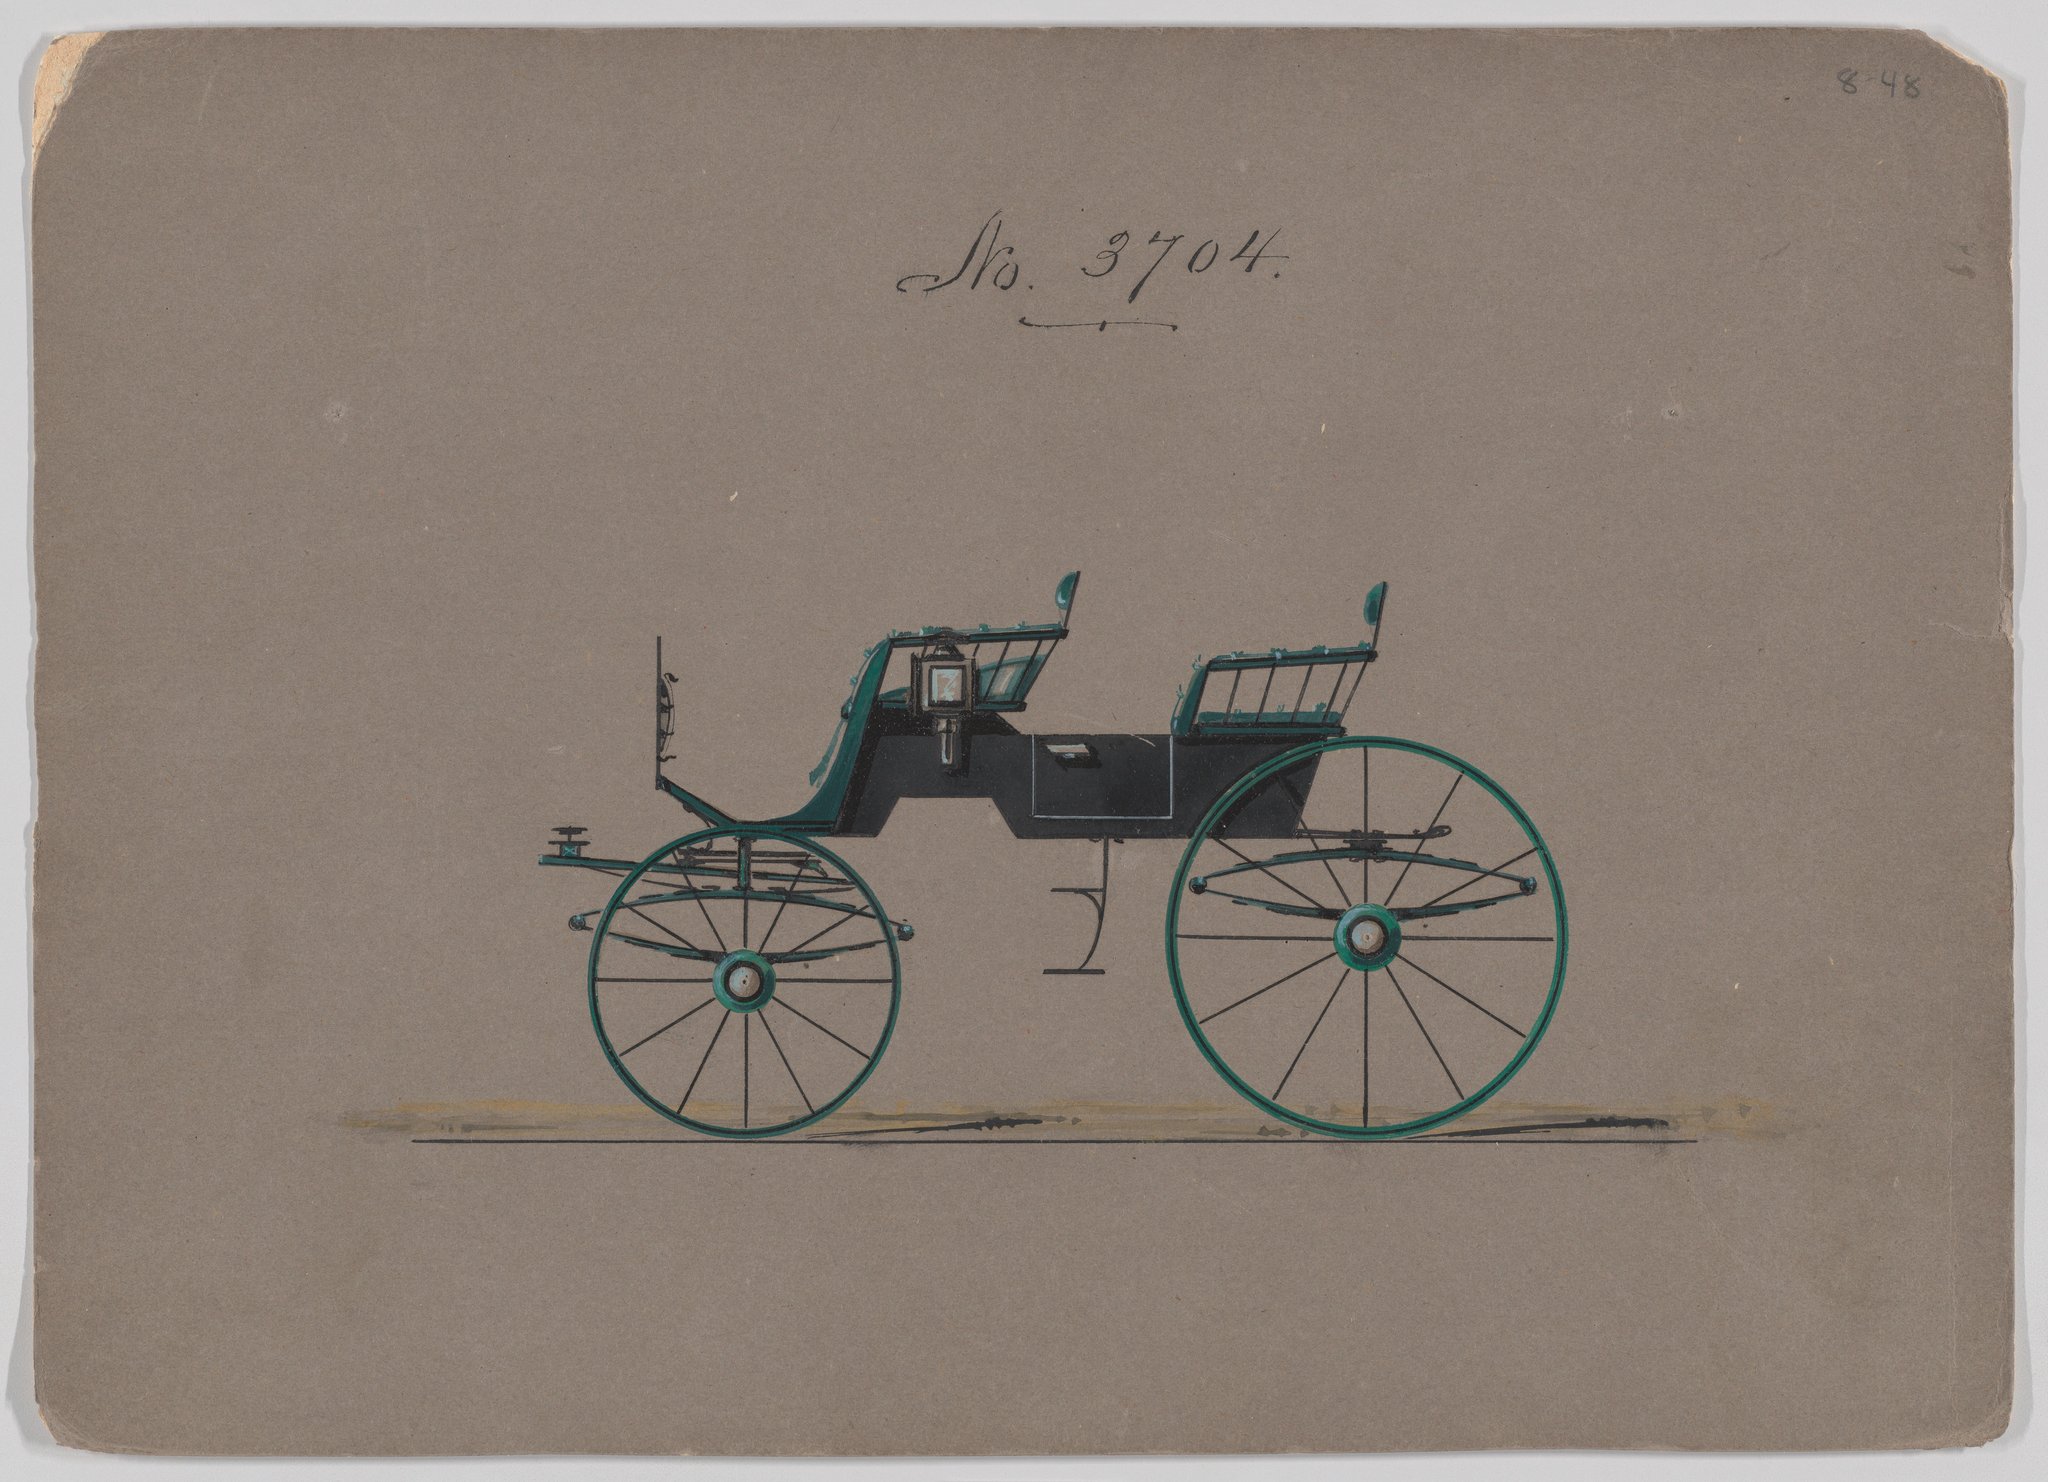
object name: drawing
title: Design for 4 seat Phaeton, no top, no. 3704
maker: brewster & co.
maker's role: manufacturer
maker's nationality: american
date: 1881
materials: gouache, ink, watercolor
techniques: pen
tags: carriages